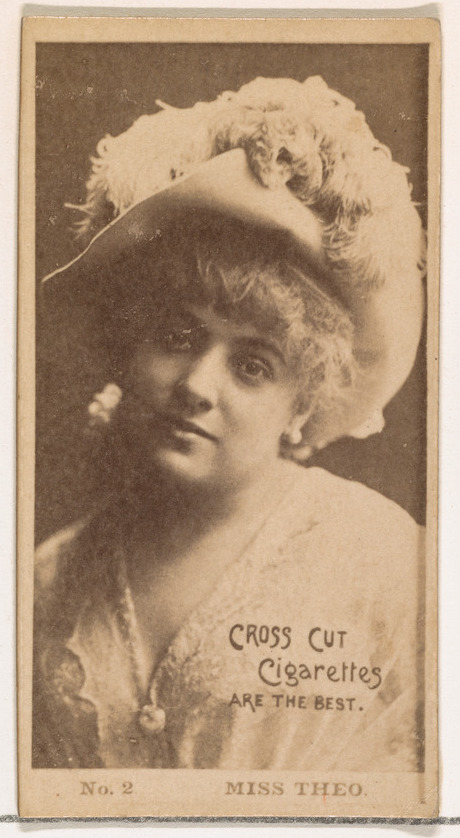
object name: print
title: Card Number 2, Miss Theo, from the Actors and Actresses series (N145-2) issued by Duke Sons & Co. to promote Cross Cut Cigarettes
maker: w. duke, sons & co.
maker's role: publisher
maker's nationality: american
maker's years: 1870-1920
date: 1880-1889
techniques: albumen silver print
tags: portraits,women,actresses